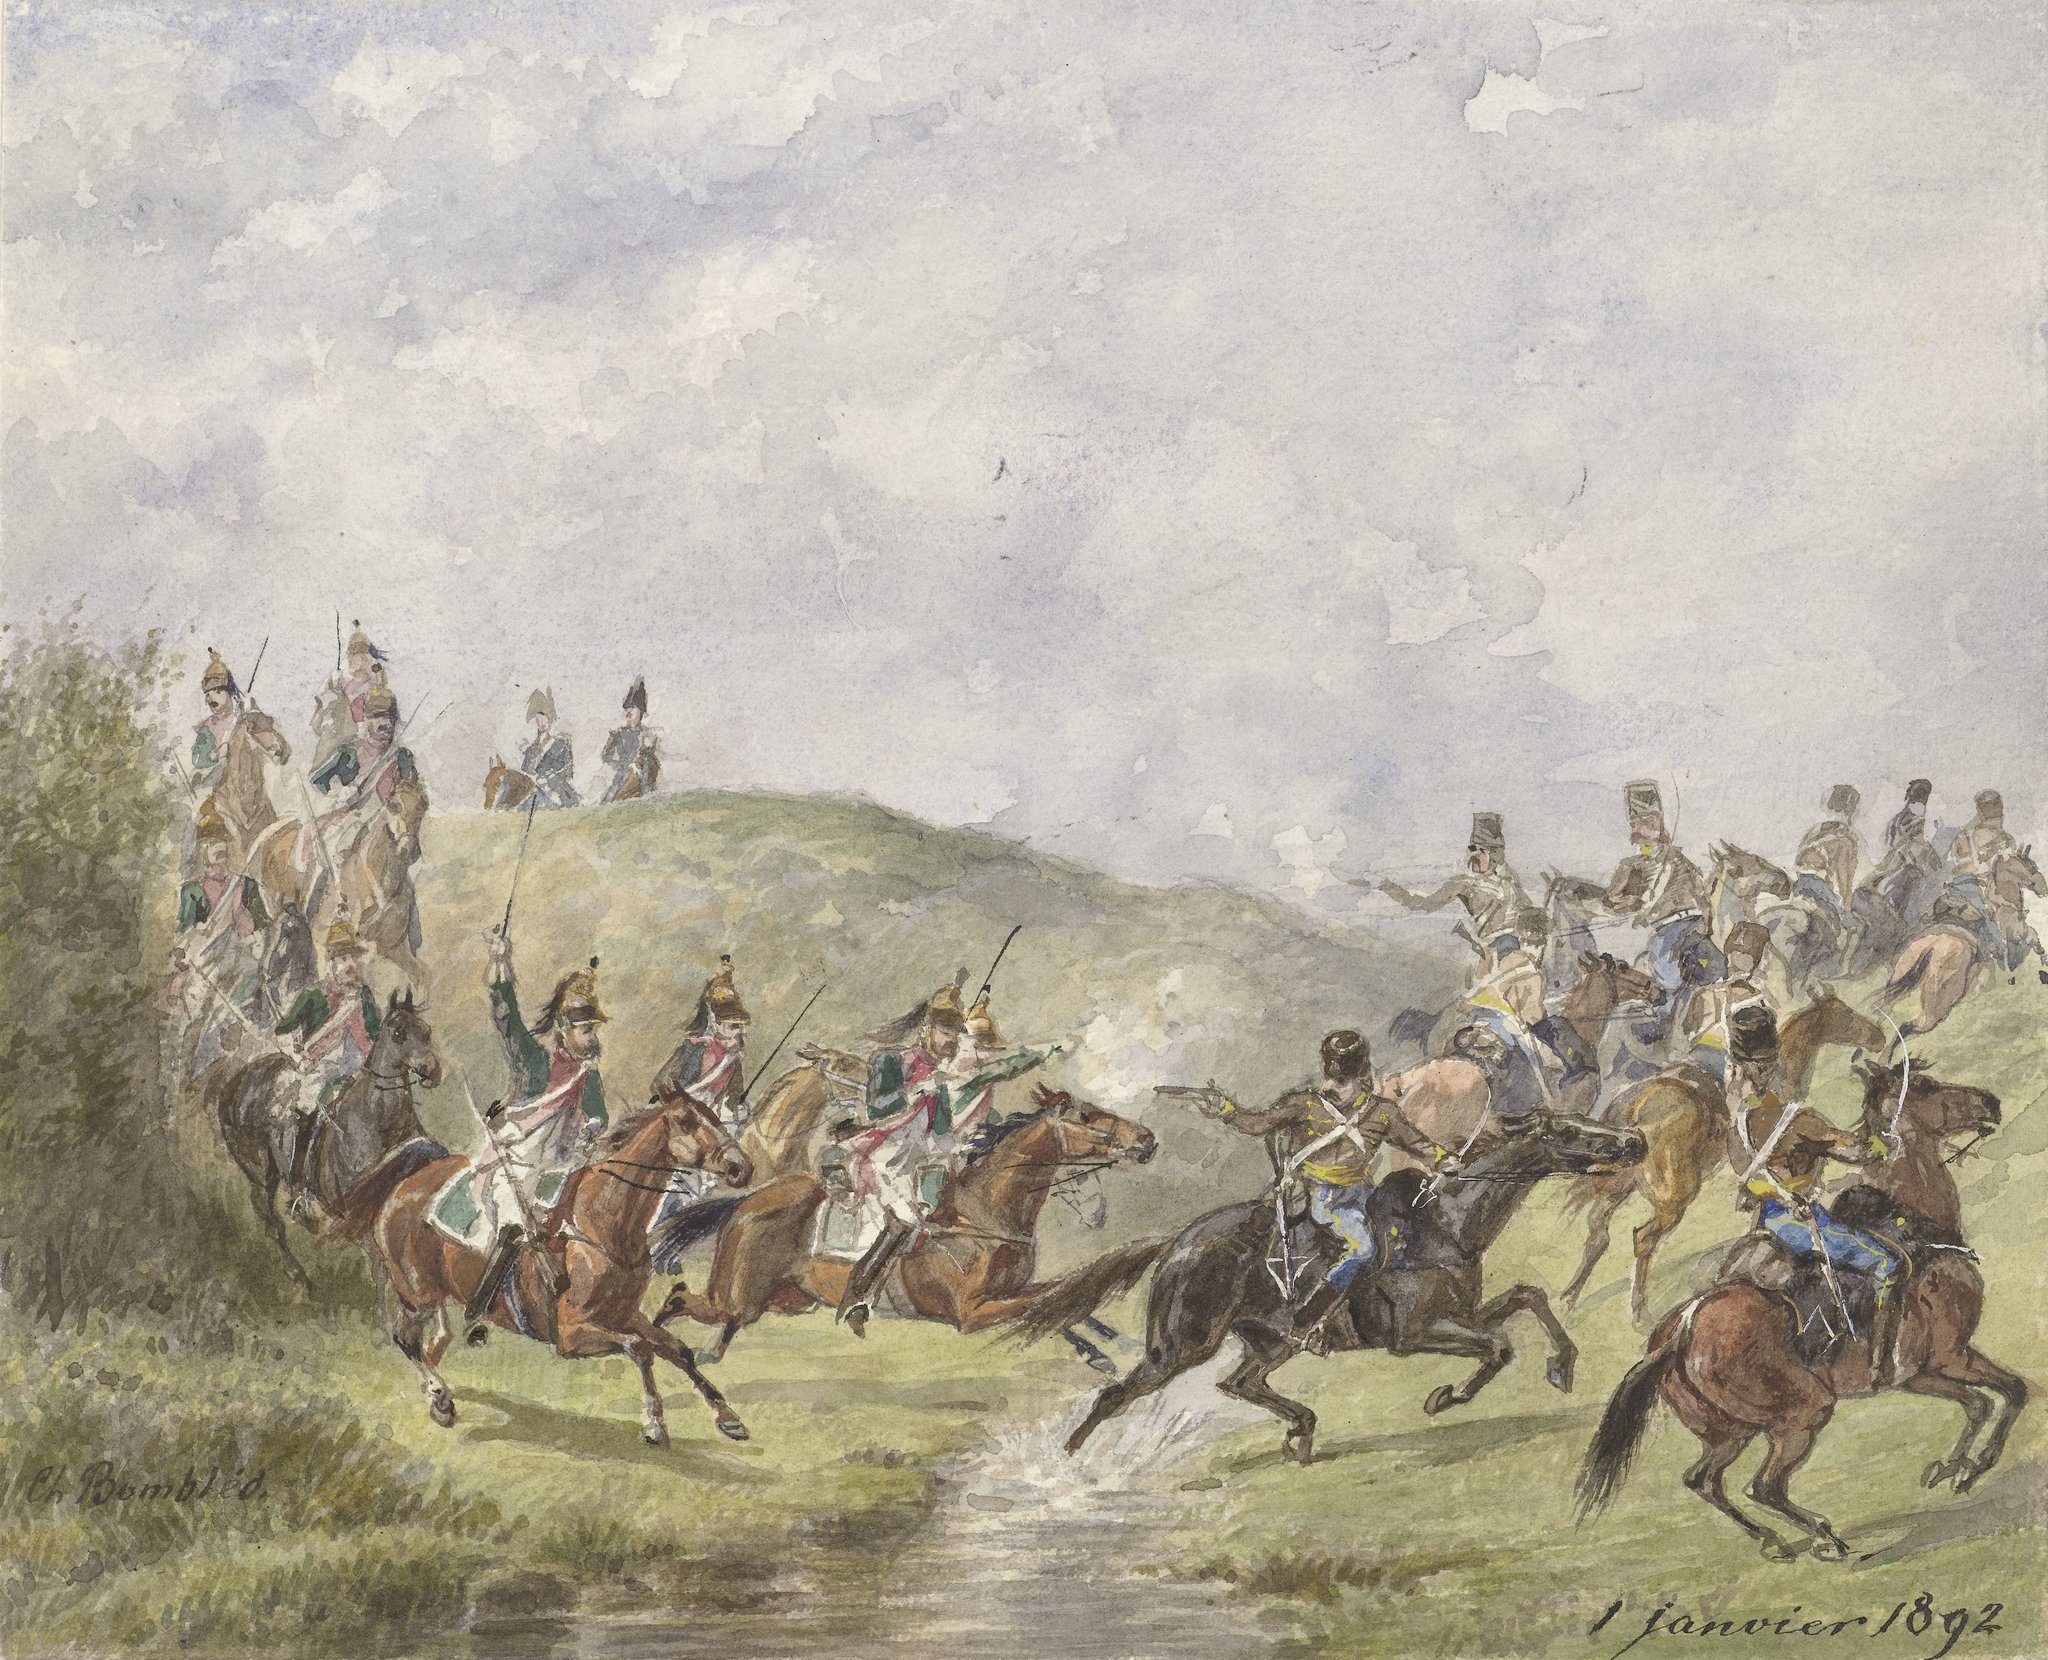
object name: watercolor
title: Franse dragonders en Oostenrijkse huzaren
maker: karel frederik bombled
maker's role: draughtsman, print maker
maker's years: 1822-1902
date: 1892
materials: paper, watercolor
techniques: brush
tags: private soldier (+ cavalry, horsemen), battle (+ cavalry, horsemen)